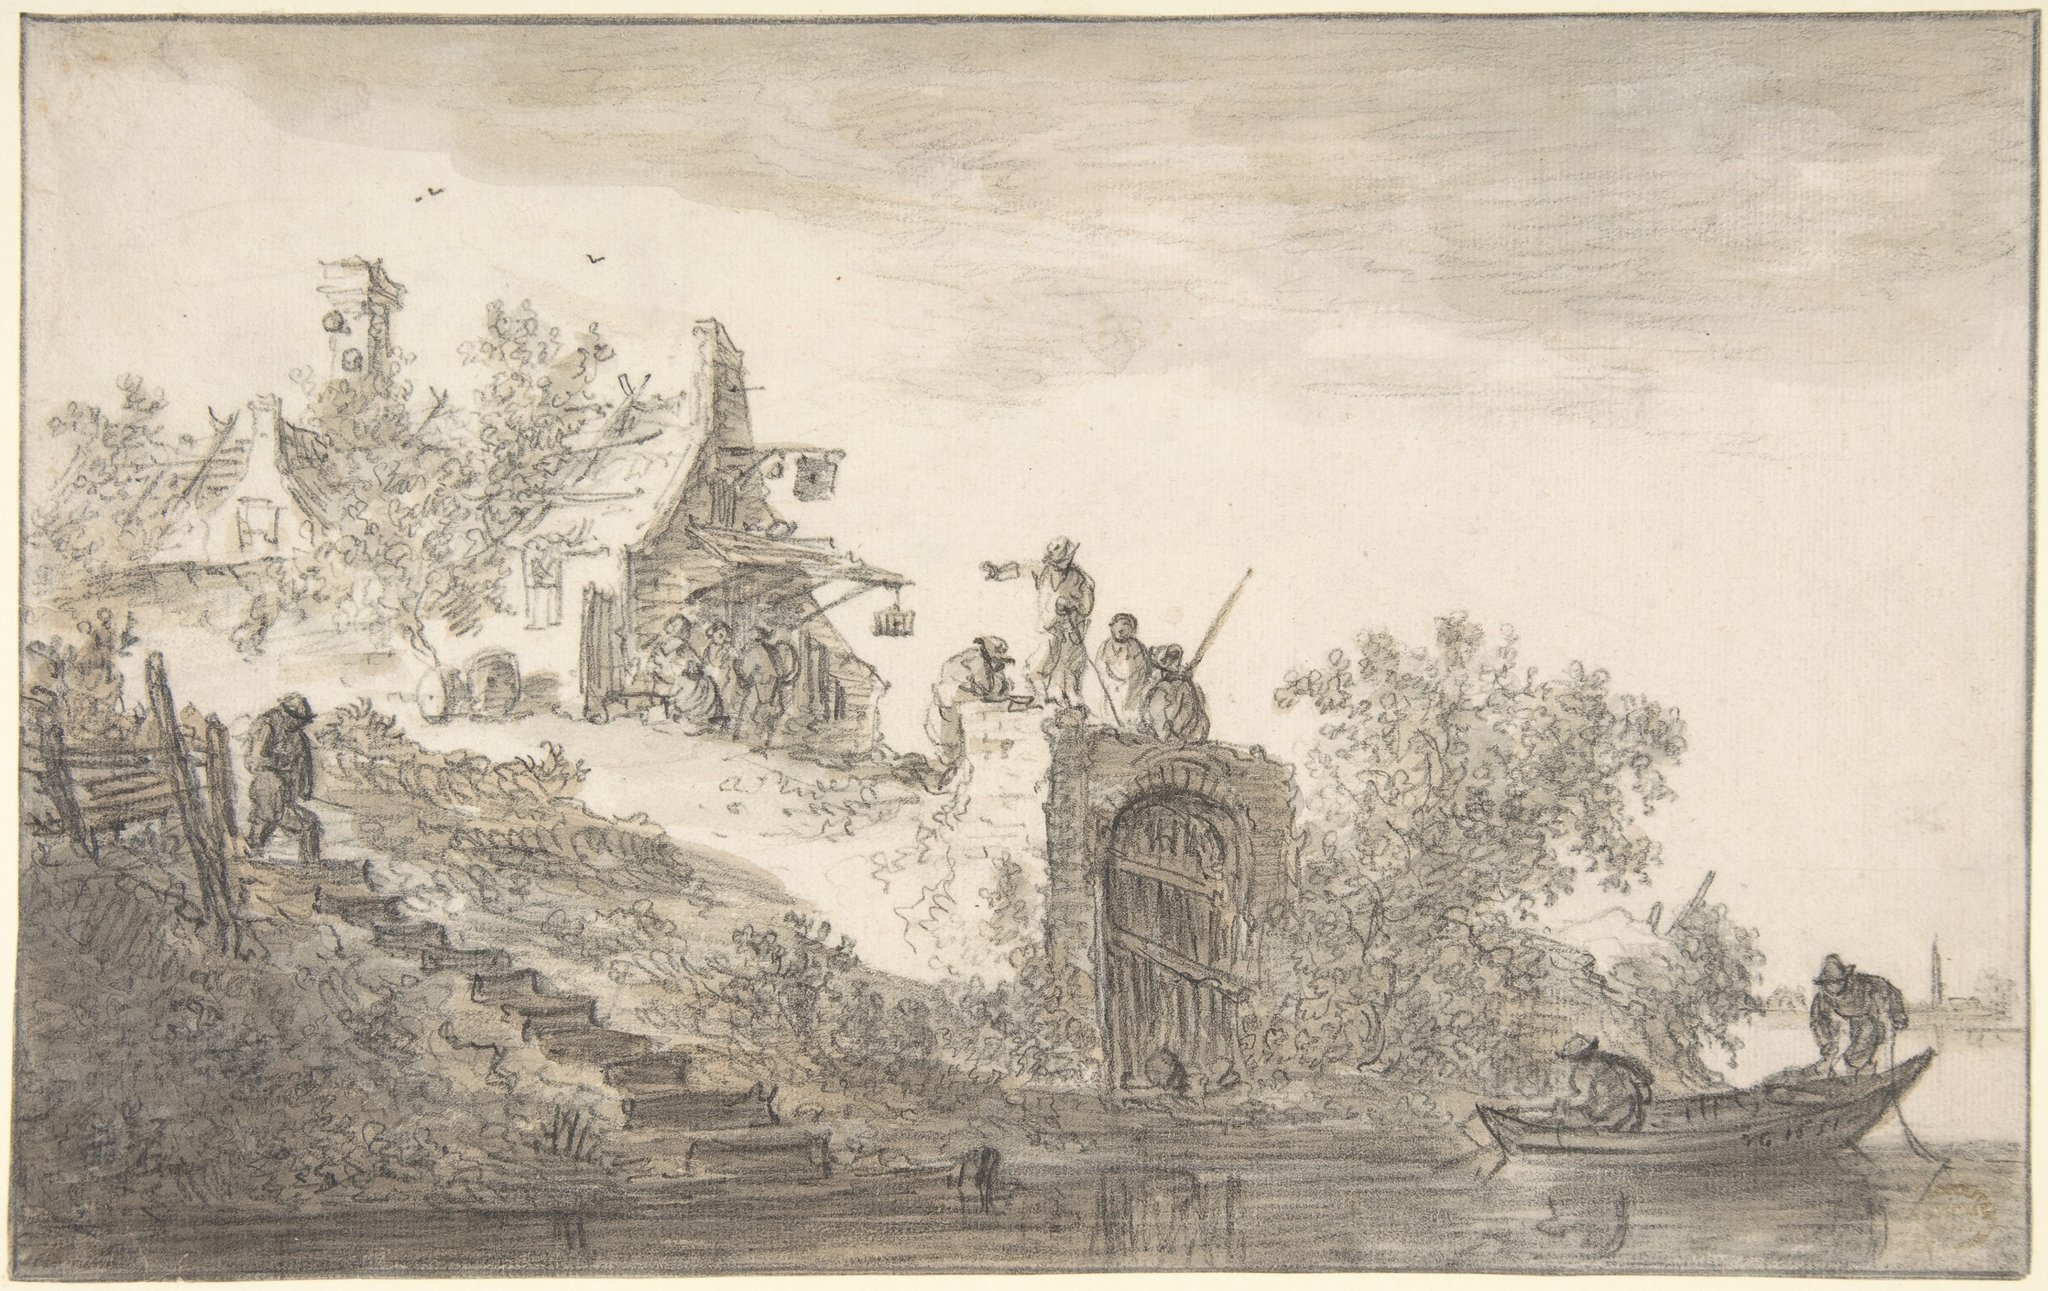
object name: drawing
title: Landscape with Figures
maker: jan van goyen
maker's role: artist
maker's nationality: dutch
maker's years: 1596-1656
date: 1651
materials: chalk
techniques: wash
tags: human figures,houses,landscapes,trees,boats